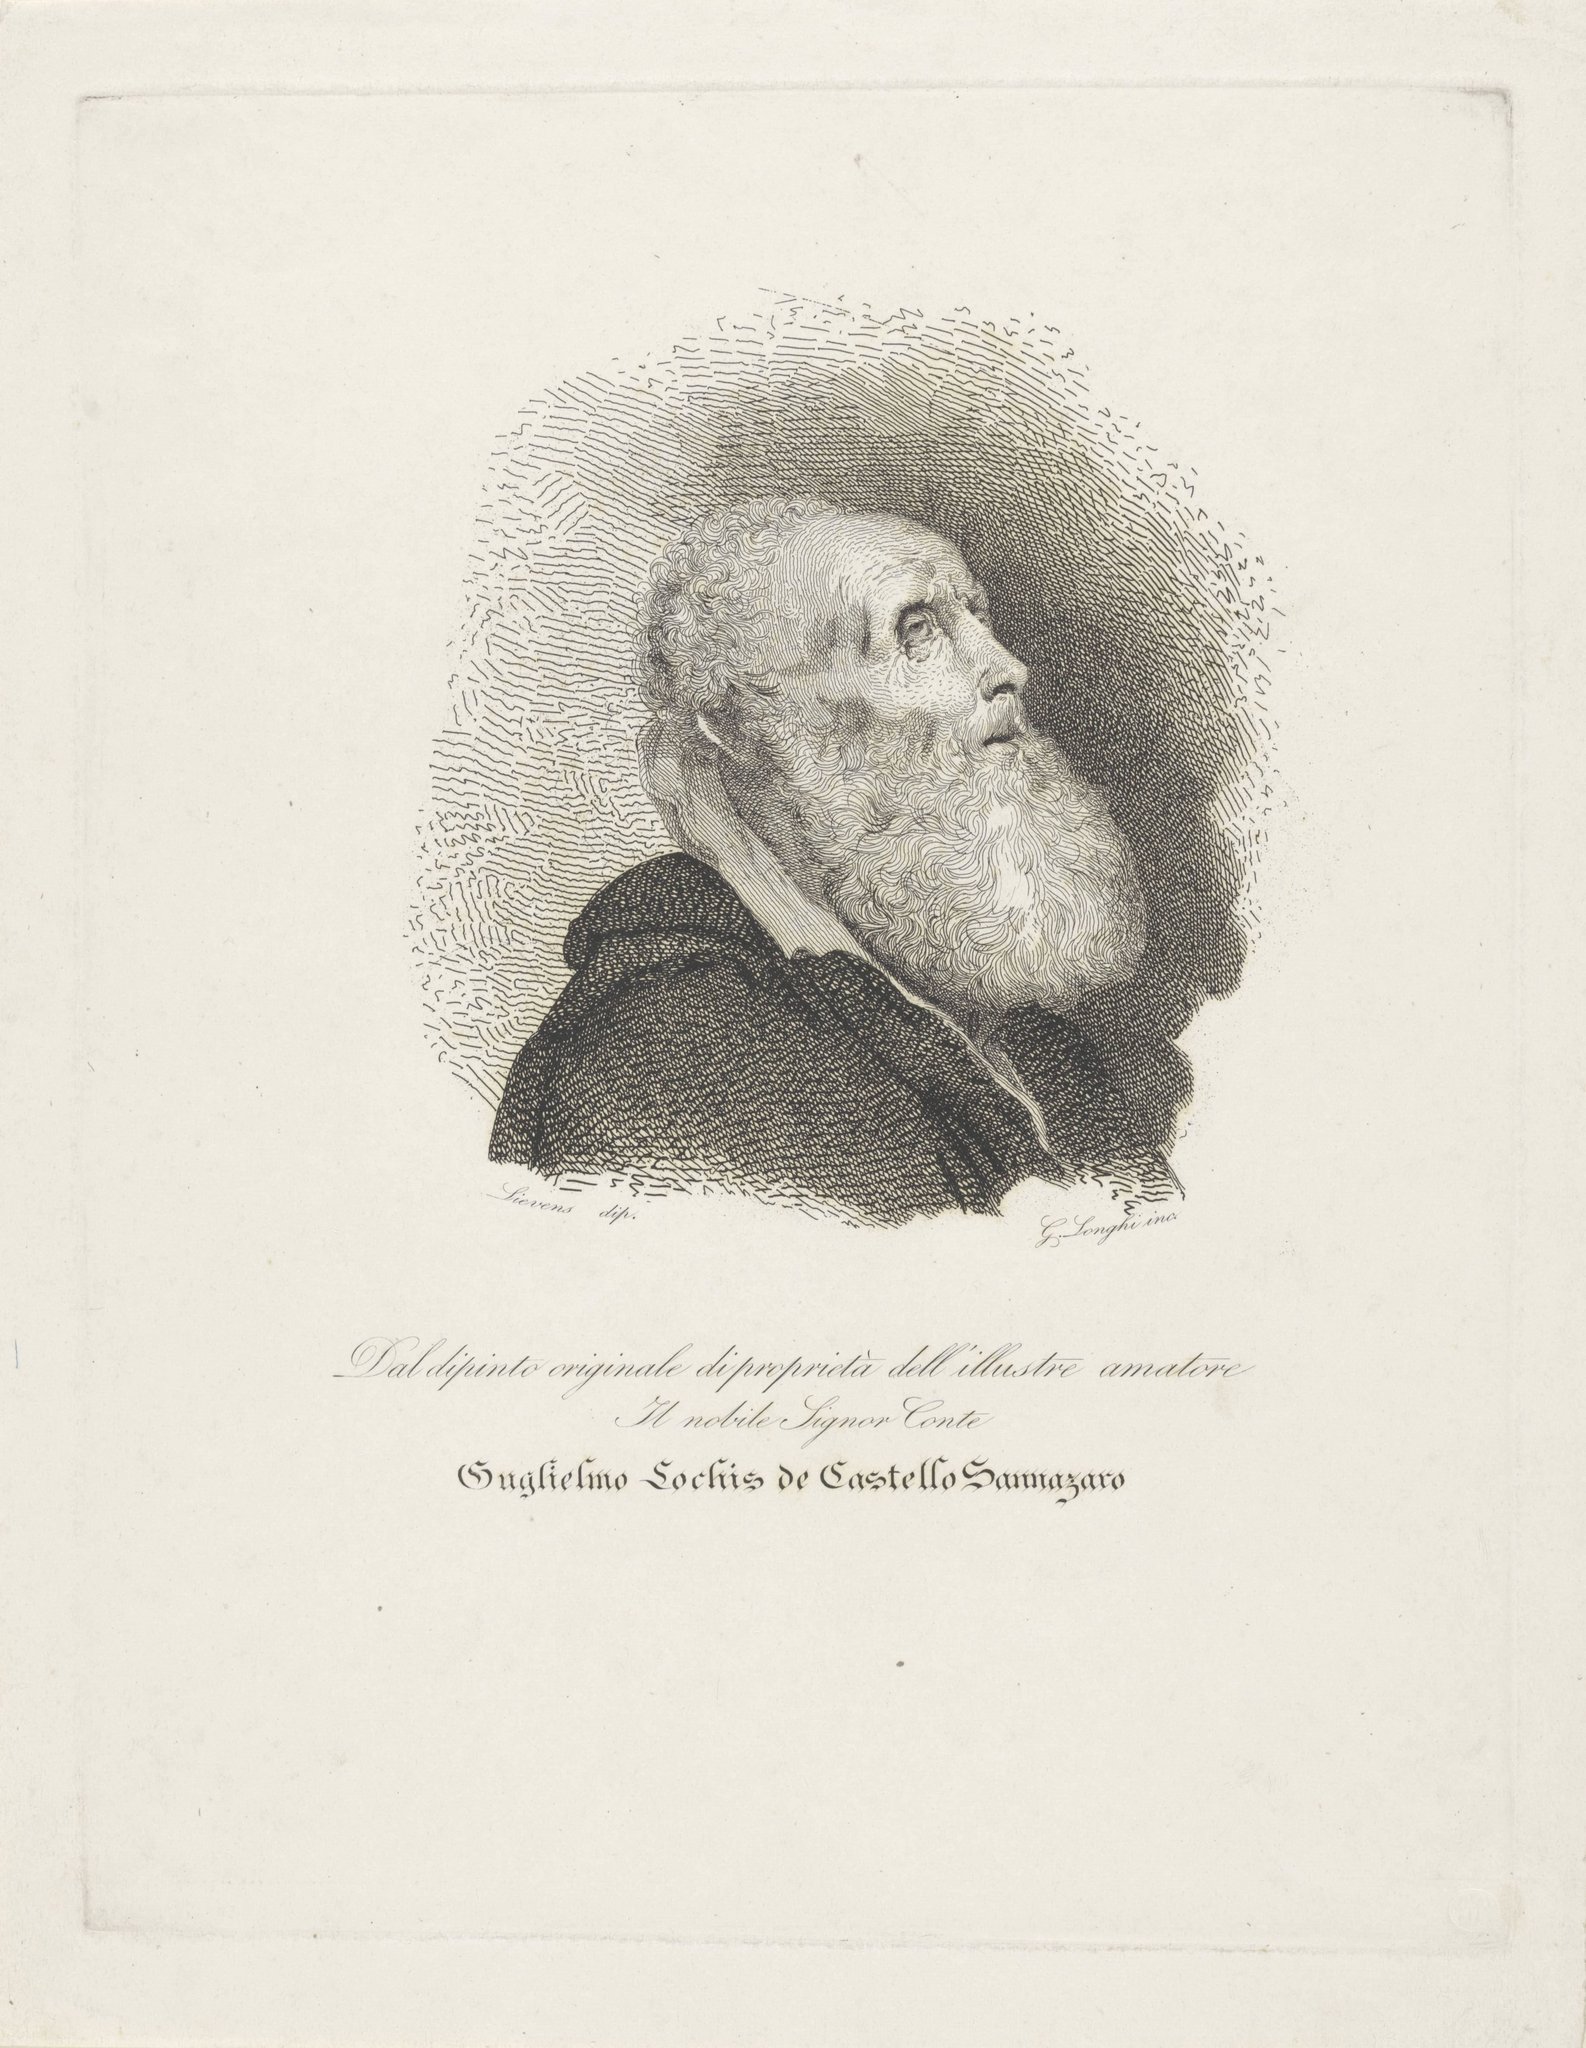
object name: print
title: Studie van een oude man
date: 1776-1831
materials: paper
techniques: etching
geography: italy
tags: historical persons, old man, simeon christophorus (the just, the grey); possible attributes: the infant christ in his arms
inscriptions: collector's mark: Lugt 2228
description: Naar schilderij door Lievens in de Pinacoteca dell'Accademia Carrara, Bergamo (inv.nr.: 156).